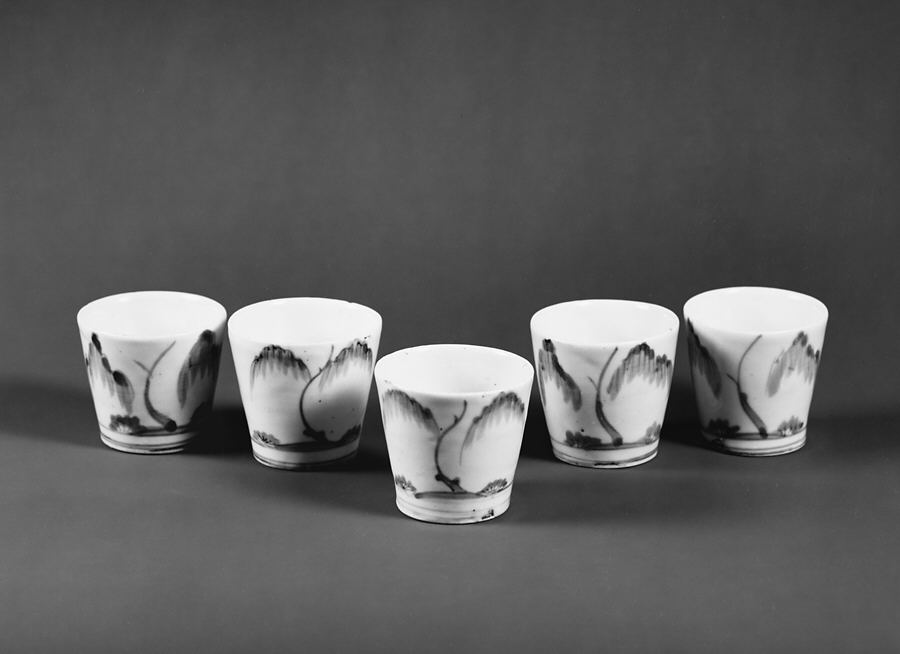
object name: soba cup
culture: japanese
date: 1667-1733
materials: porcelain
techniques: underglaze